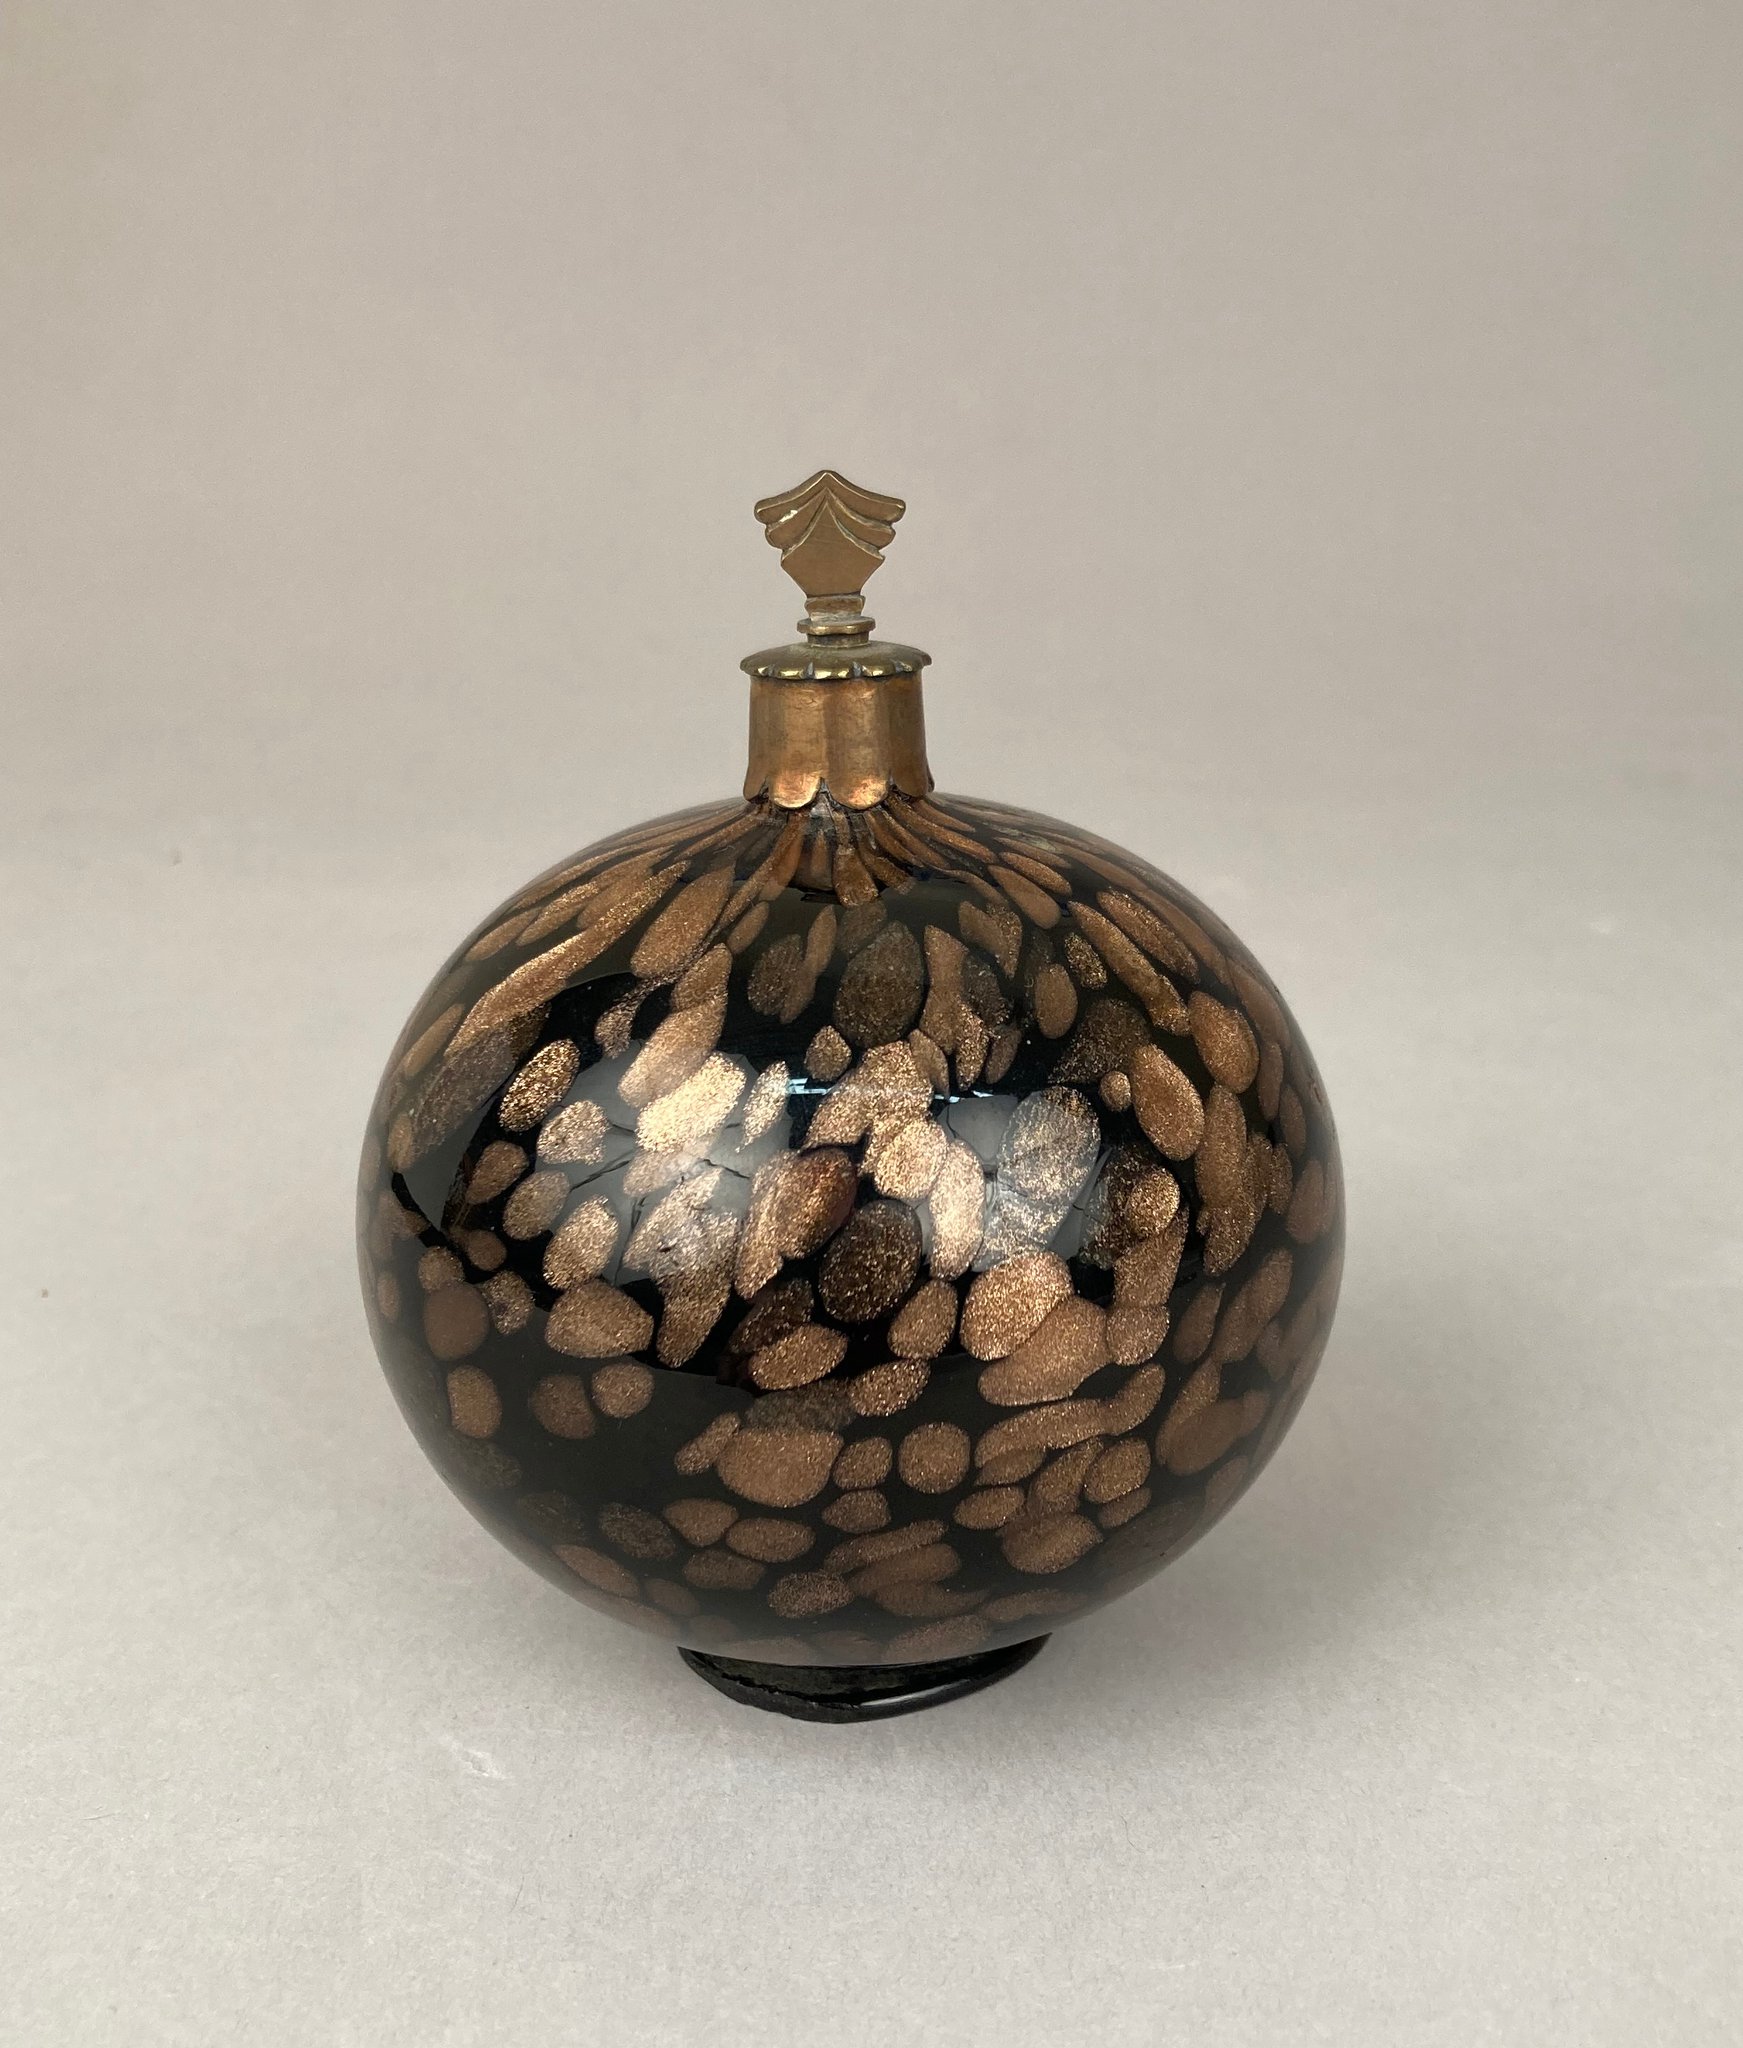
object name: bottle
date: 1601-1700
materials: glass, metal